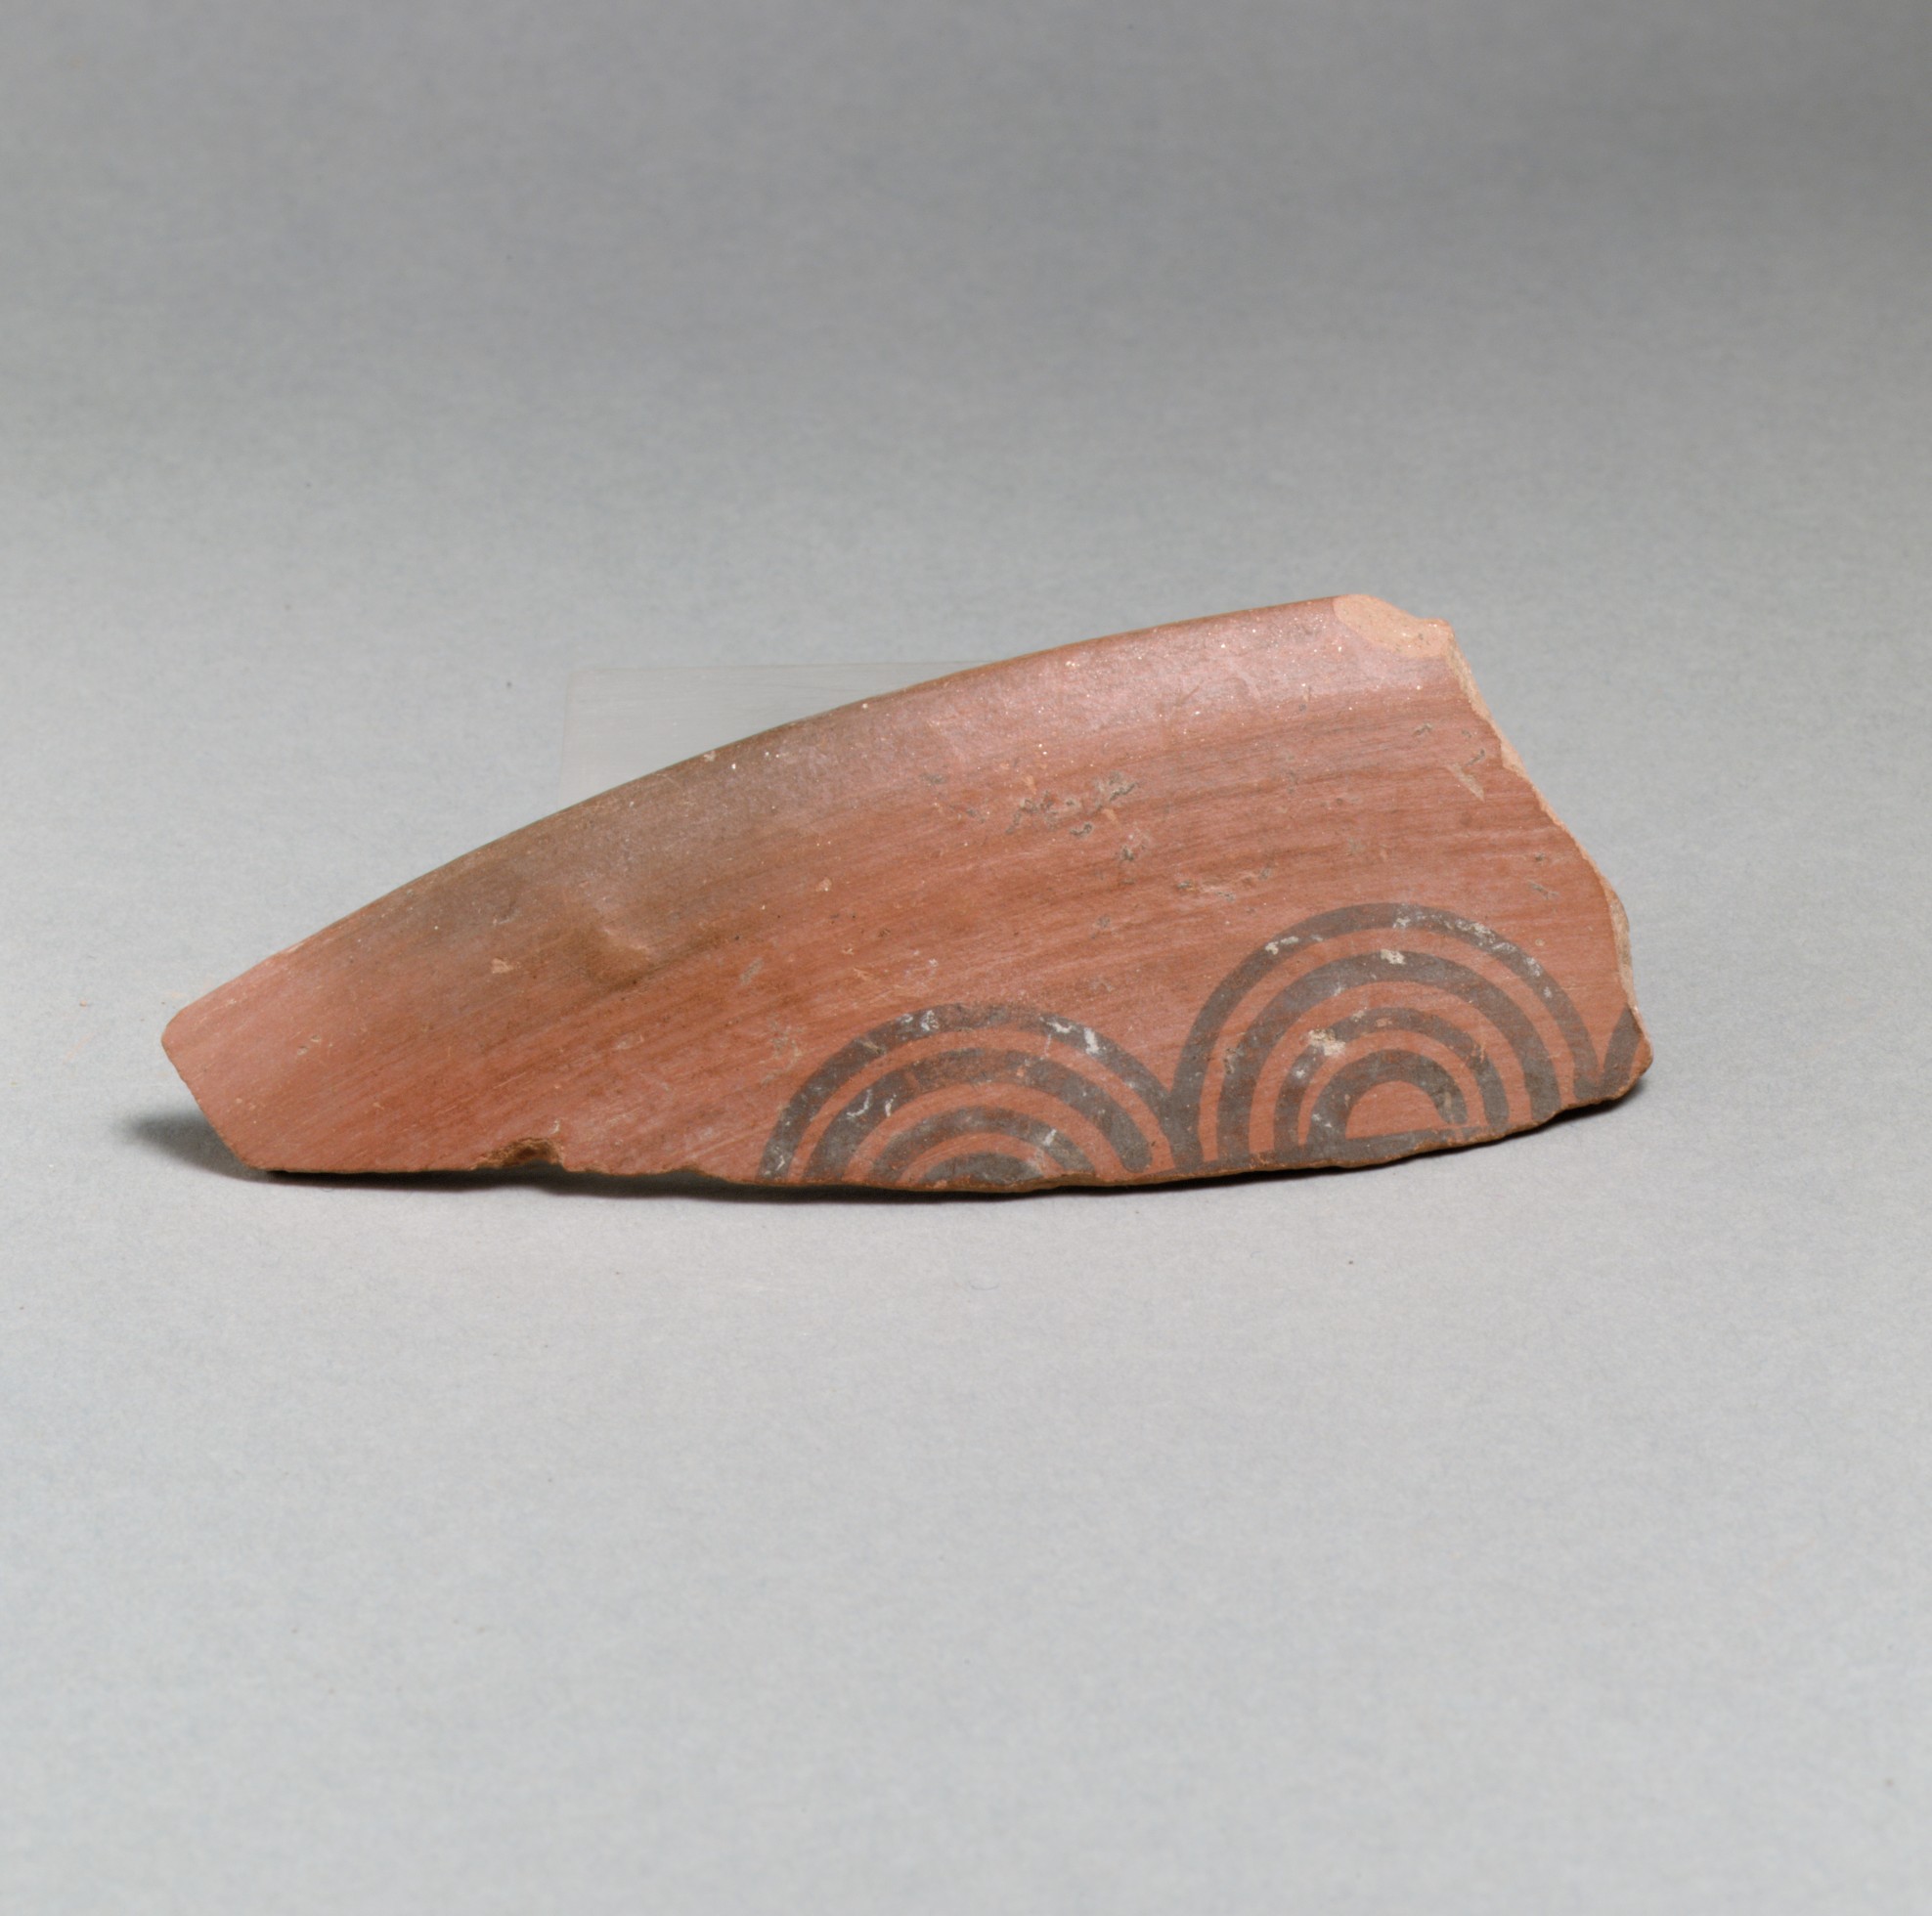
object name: vase fragment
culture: greek or lydian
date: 1050-700 BCE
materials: terracotta